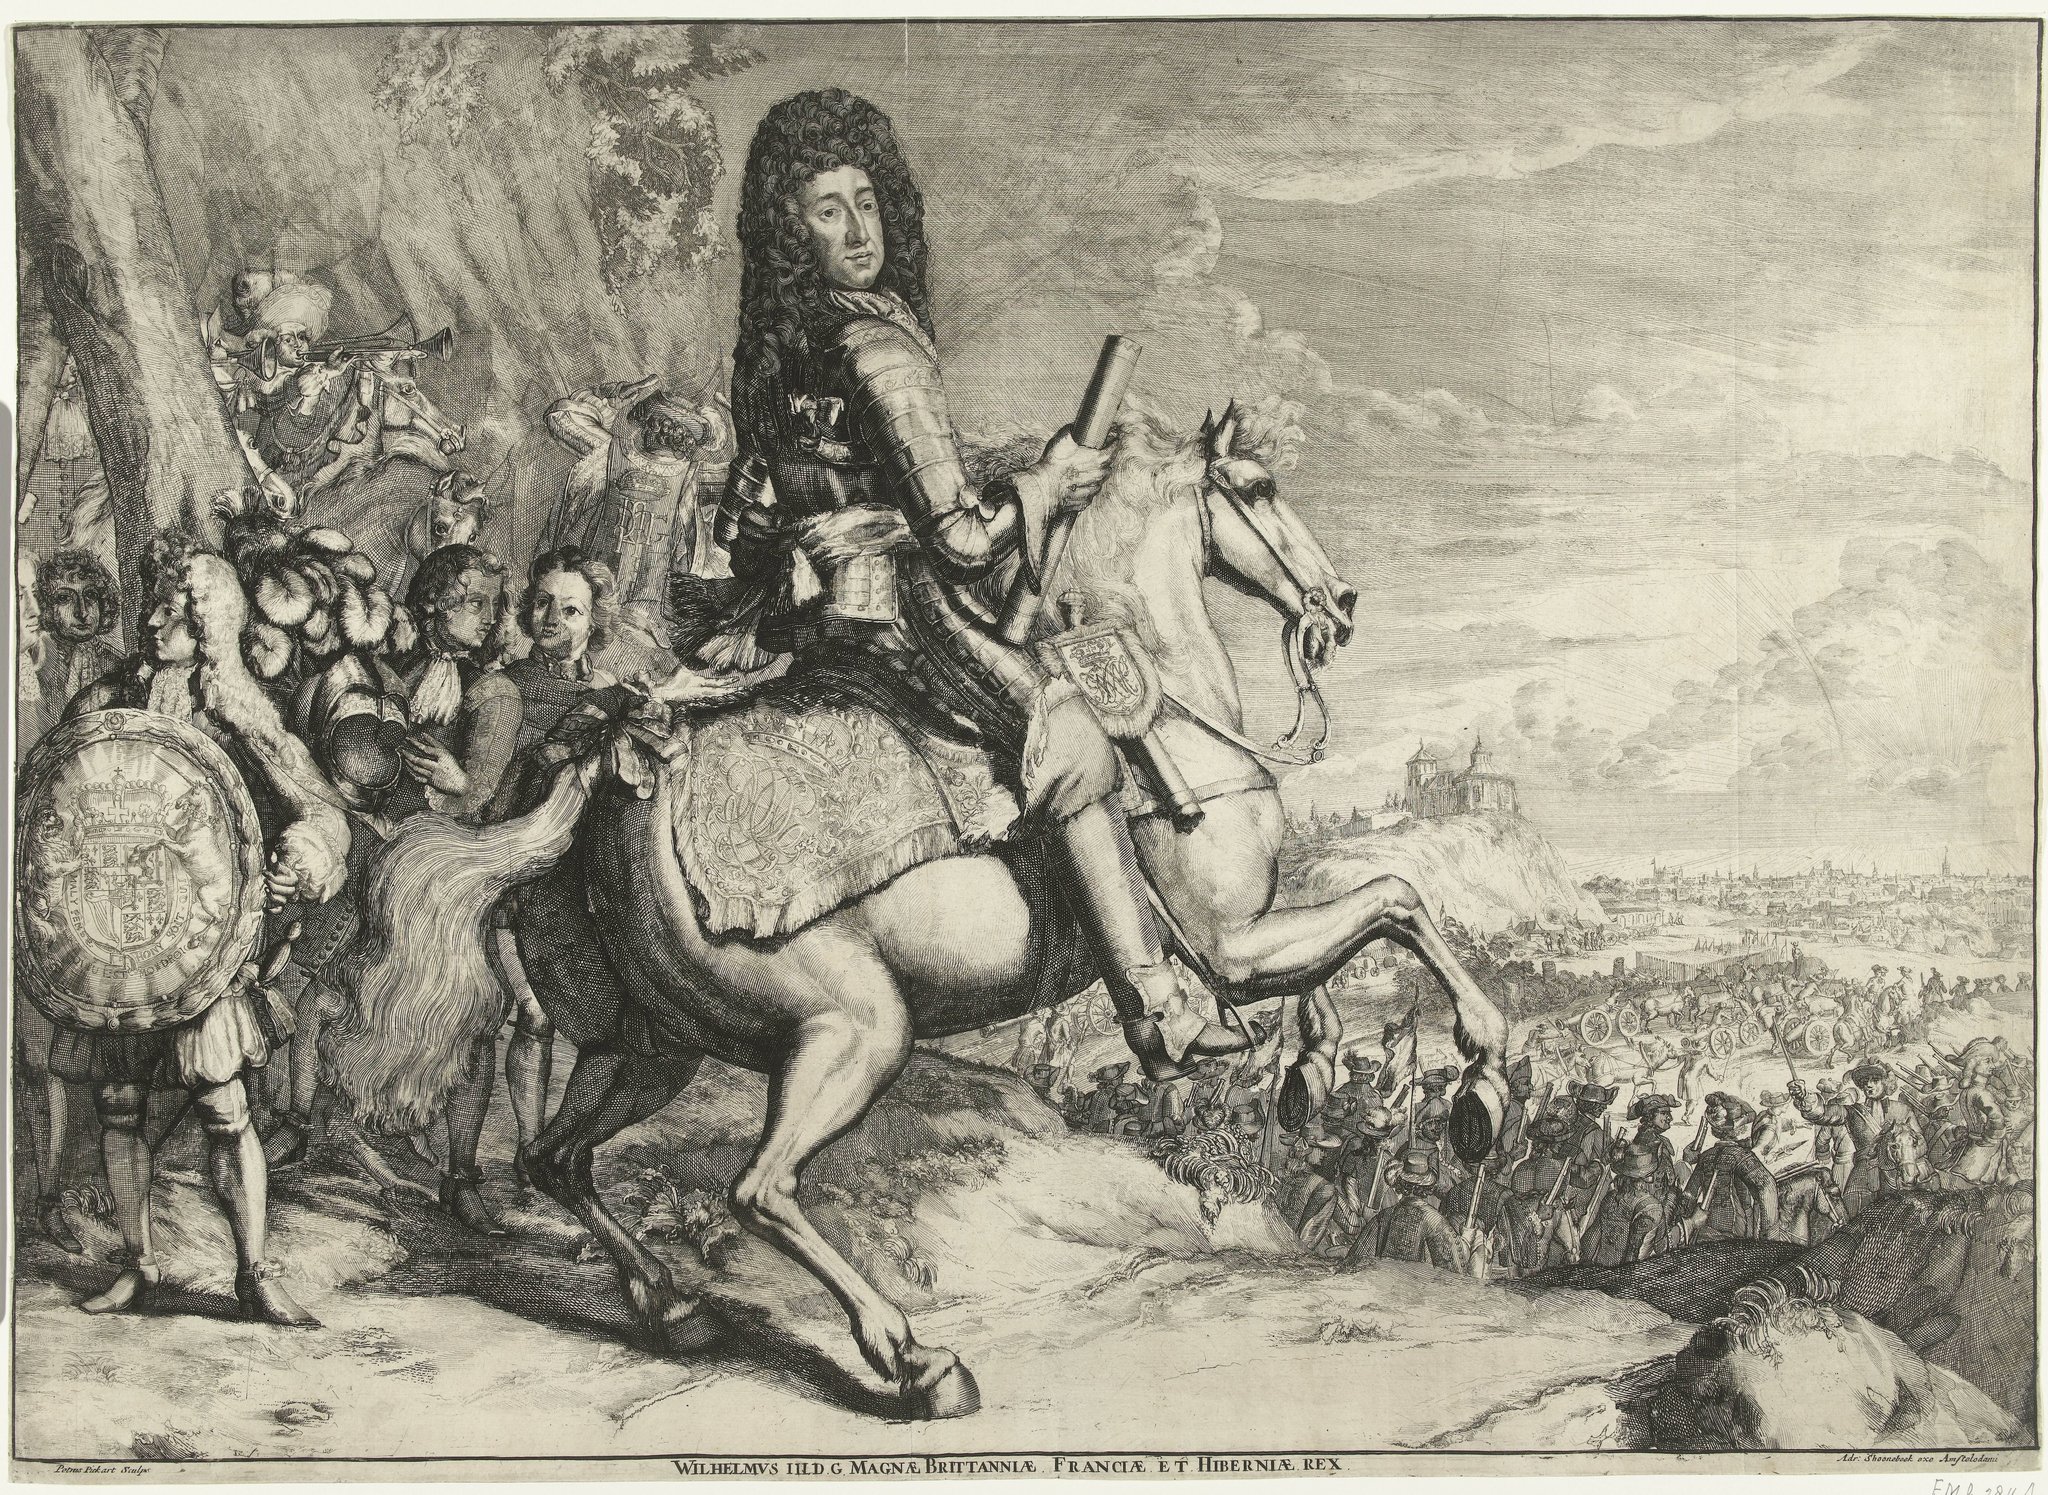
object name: print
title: Ruiterportret van Willem III, prins van Oranje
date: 1689-1691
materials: paper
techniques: engraving, etching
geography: amsterdam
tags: william iii (prince of orange and king of england, scotland, and ireland)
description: Ruiterportret van Willem III. In zijn rechterhand een commandostaf. Links een aantal figuren, waaronder trompetters en een paukenslager, en zijn wapen met een kroon, gedecoreerd met de Kousenband en het devies van de Orde van de Kousenband. Op de achtergrond oprukkende troepen en een belegerde stad waarboven de zon schijnt, oorlogstafereel uit de strijd in Ierland. In de ondermarge zijn naam en titels.